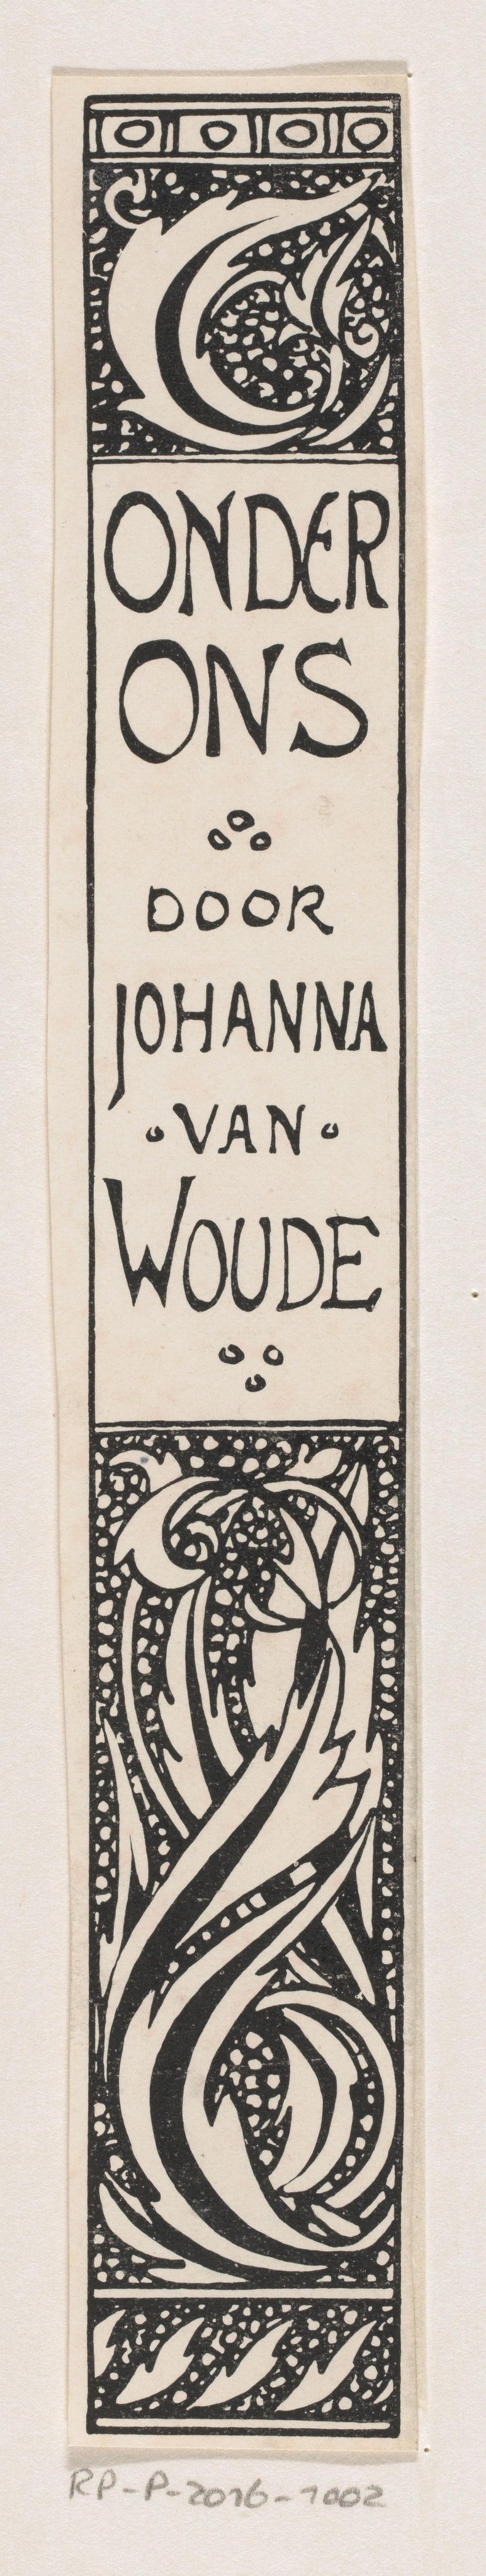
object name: photomechanical print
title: Ontwerp voor een boekrug voor: Johanna van Woude, Onder ons, 1898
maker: Anonymous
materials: paper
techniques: printing block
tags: flowers ~ ornament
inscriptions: collector's mark: Lugt 2228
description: Ontwerp met florale ornamenten boven en onder de boektitel en auteursnaam.